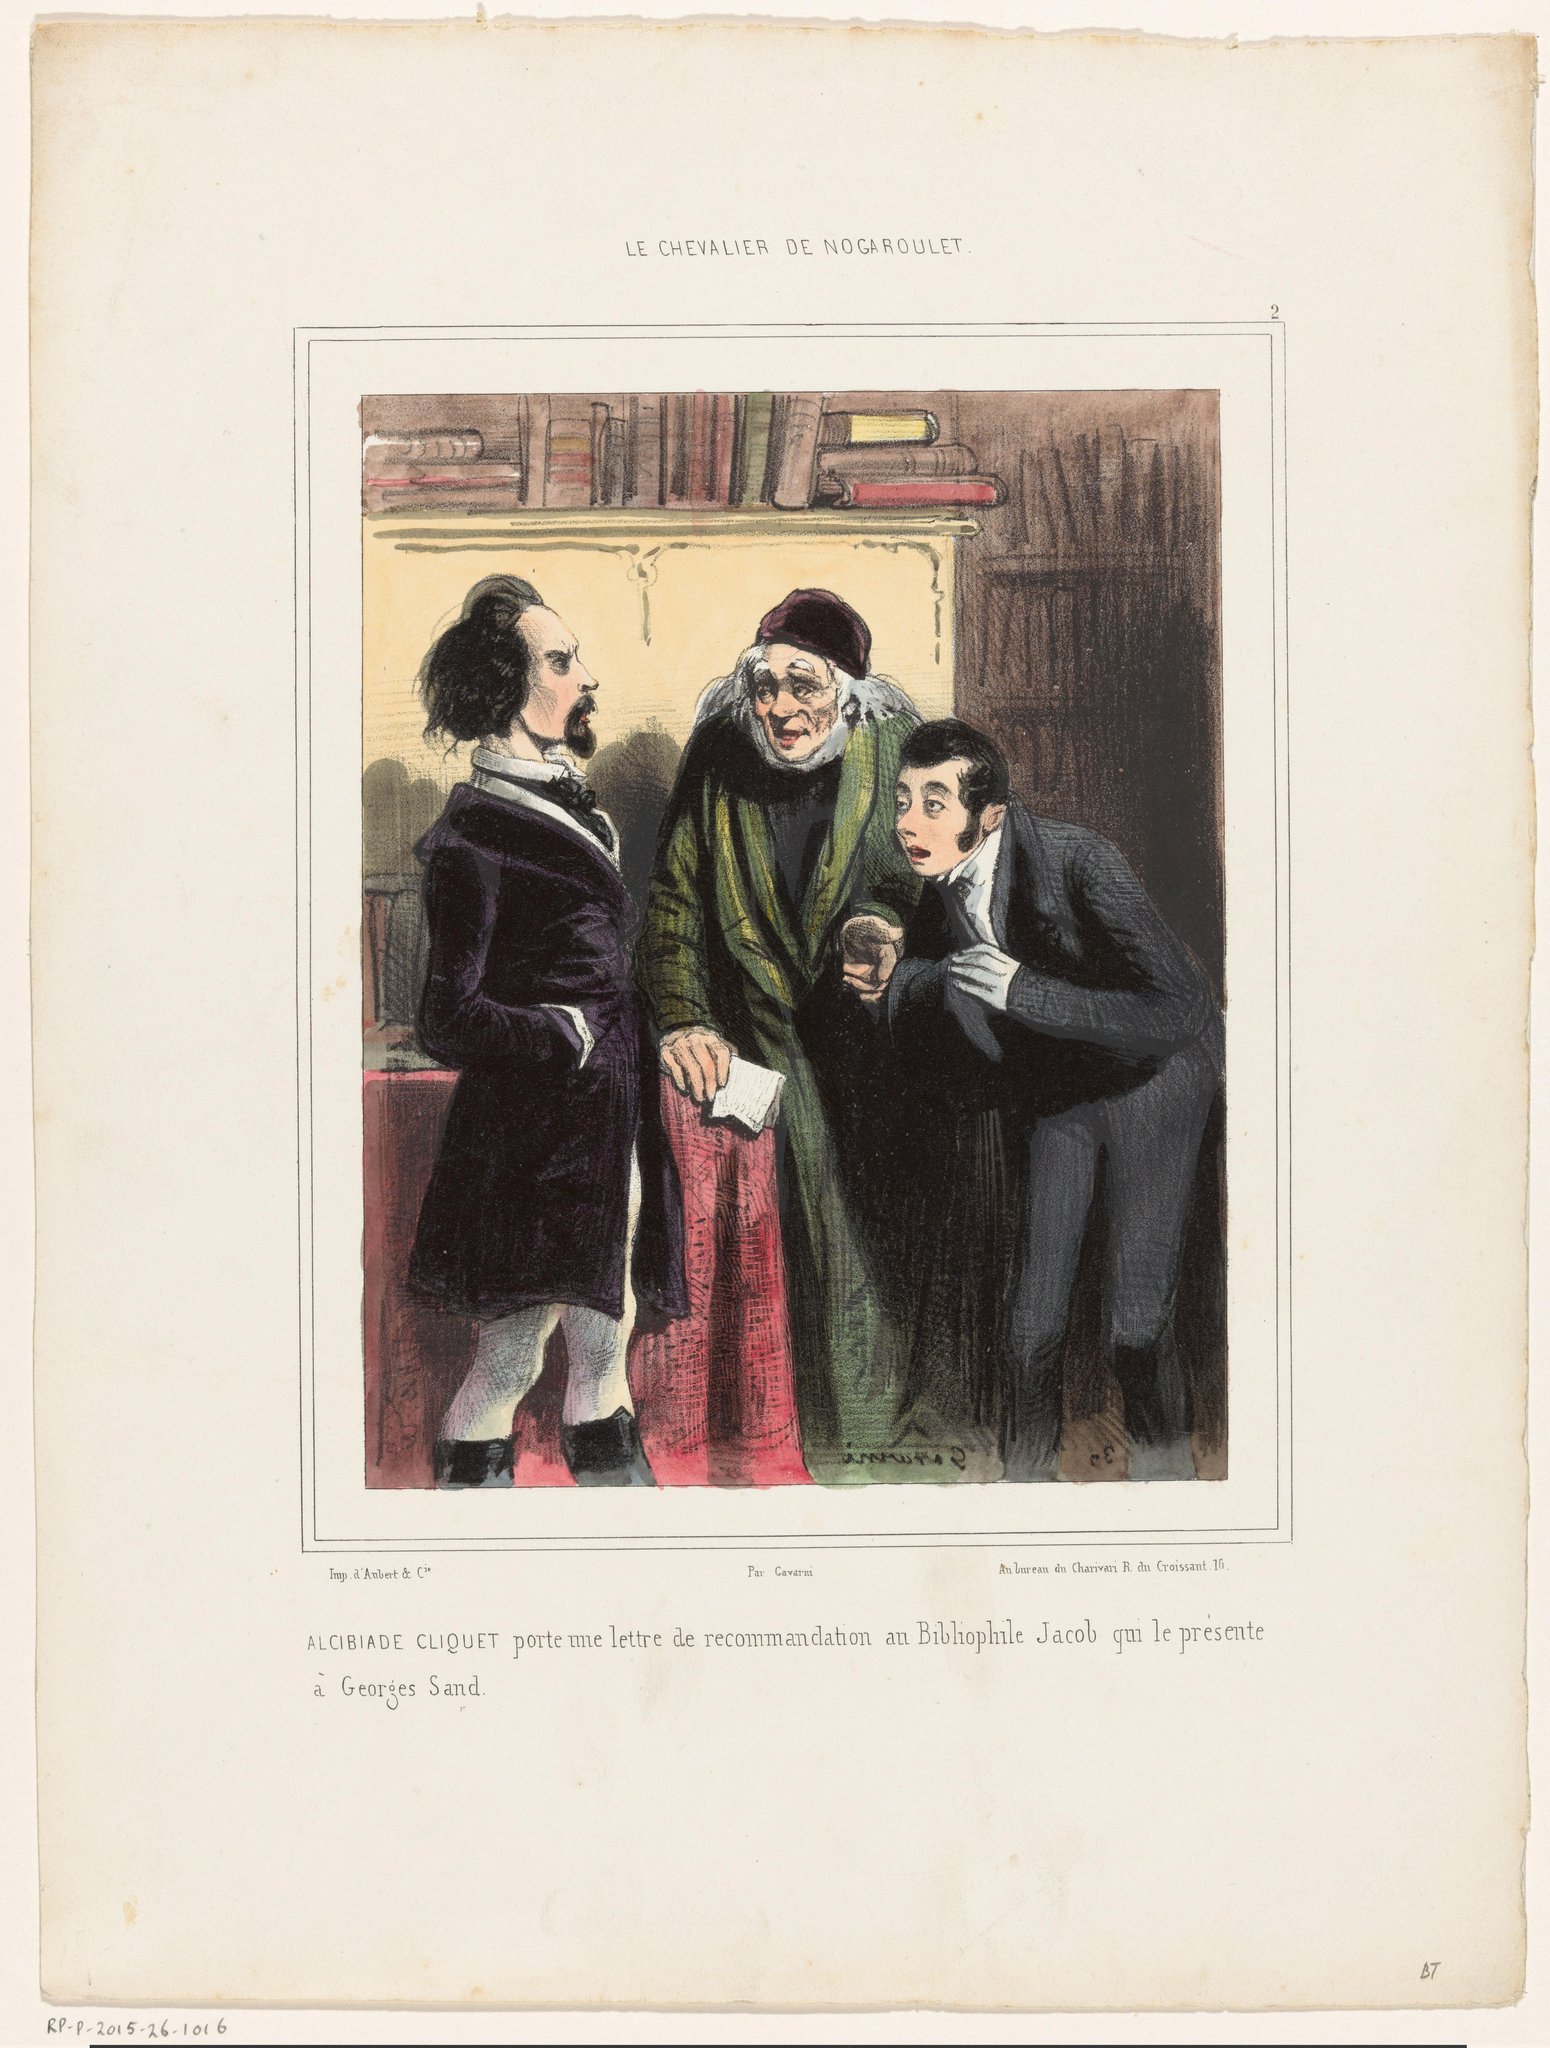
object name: print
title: Le chevalier de Nogaroulet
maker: paul gavarni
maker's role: draughtsman, print maker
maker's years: 1804-1866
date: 1807-1839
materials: paper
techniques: hand coloring, lithograph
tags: george sand, paris, paul lacroix, woman dressed as man, travesty, study; 'studiolo'; library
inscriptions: collector's mark: Lugt 2228, collector's mark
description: Interieur van een bibliotheek met drie personen. De jongeman rechts is Alcibiade Cliquet, ridder van Nogaroulet en de hoofdpersoon van de serie. Naast hem staat Bibliophile Jacob, een pseudonym van Paul Lacroix, met de aanbevelingsbrief. De persoon voor hen stelt George Sand voor, gekleed in mannenkleding en met een baard.